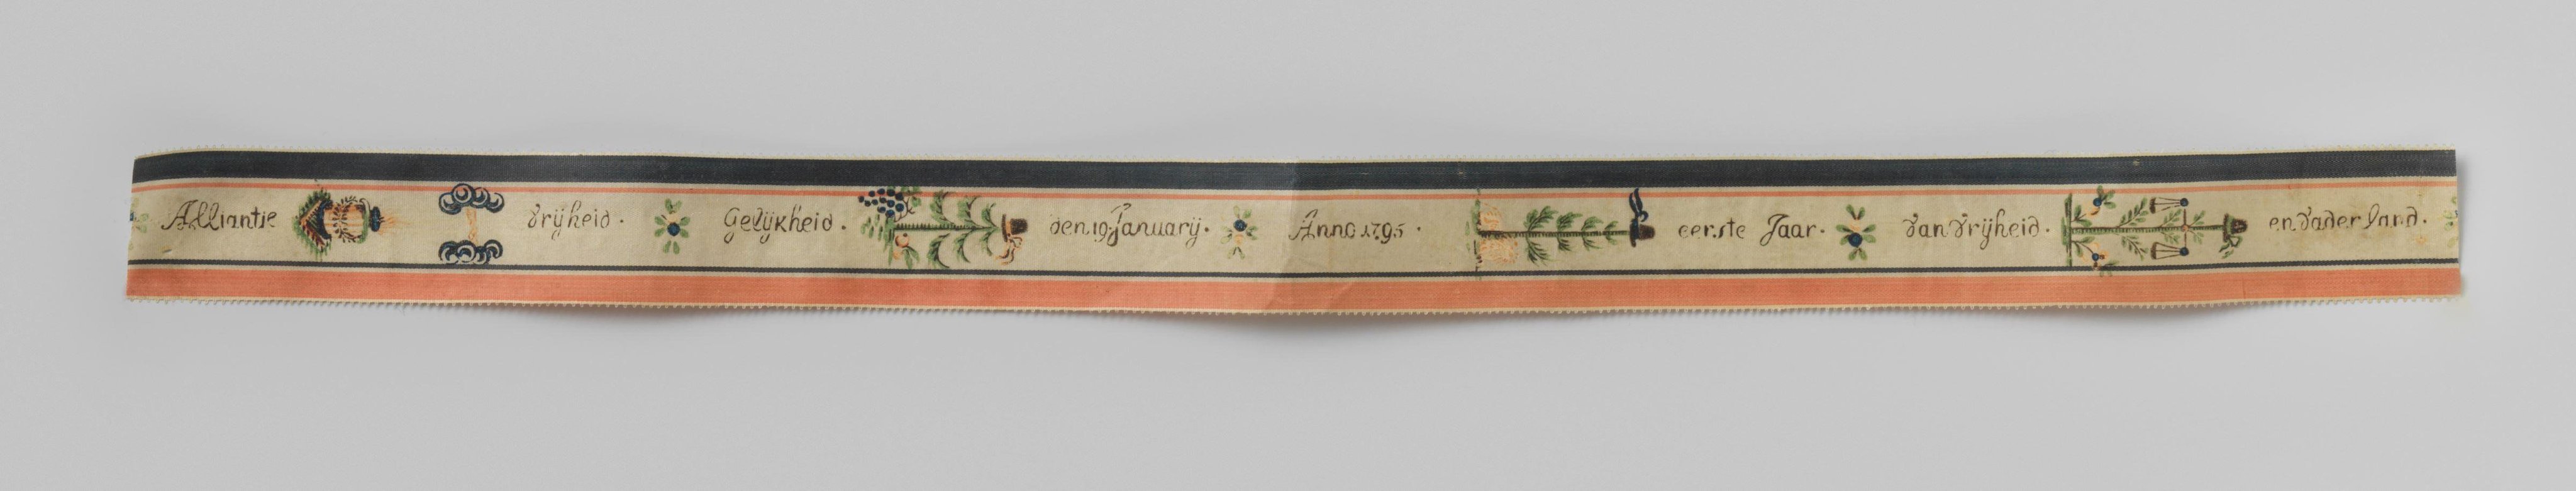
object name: ribbon material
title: Patriottenlint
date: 1795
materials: silk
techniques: printing, weave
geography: netherlands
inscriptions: date